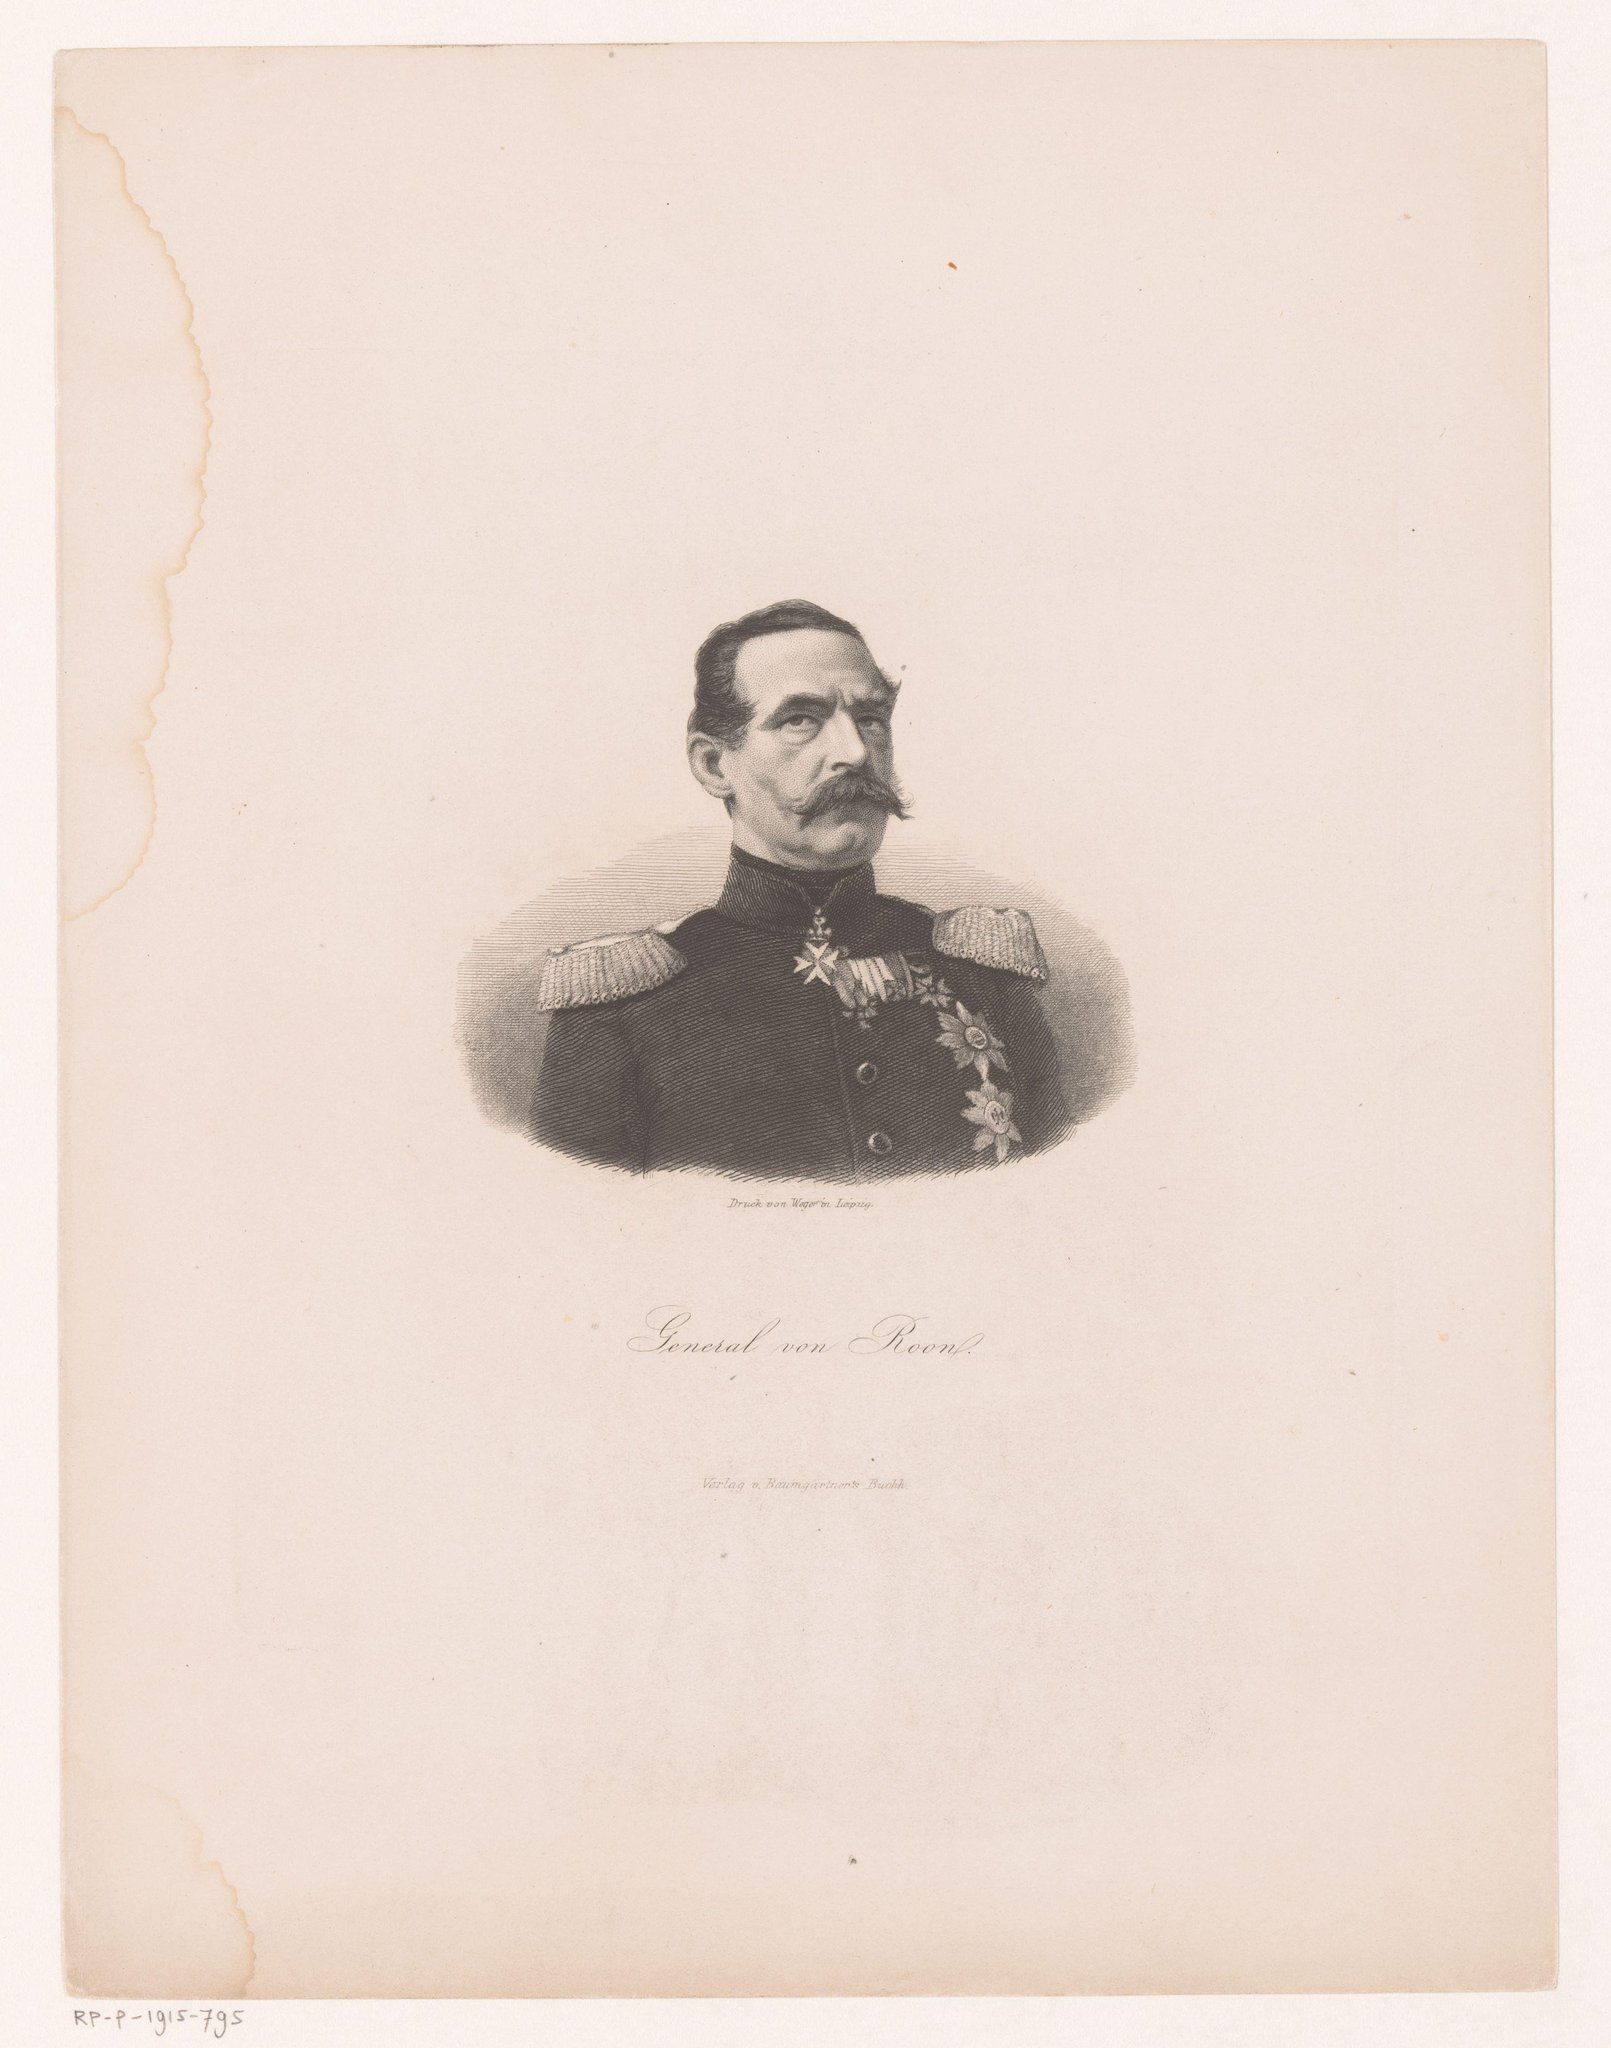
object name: print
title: Portret van Albrecht von Roon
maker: august weger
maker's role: print maker, printer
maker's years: 1823-1892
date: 1849-1892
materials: paper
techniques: engraving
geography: leipzig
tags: poland, berlin, politician, historical persons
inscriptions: collector's mark: Lugt 2228